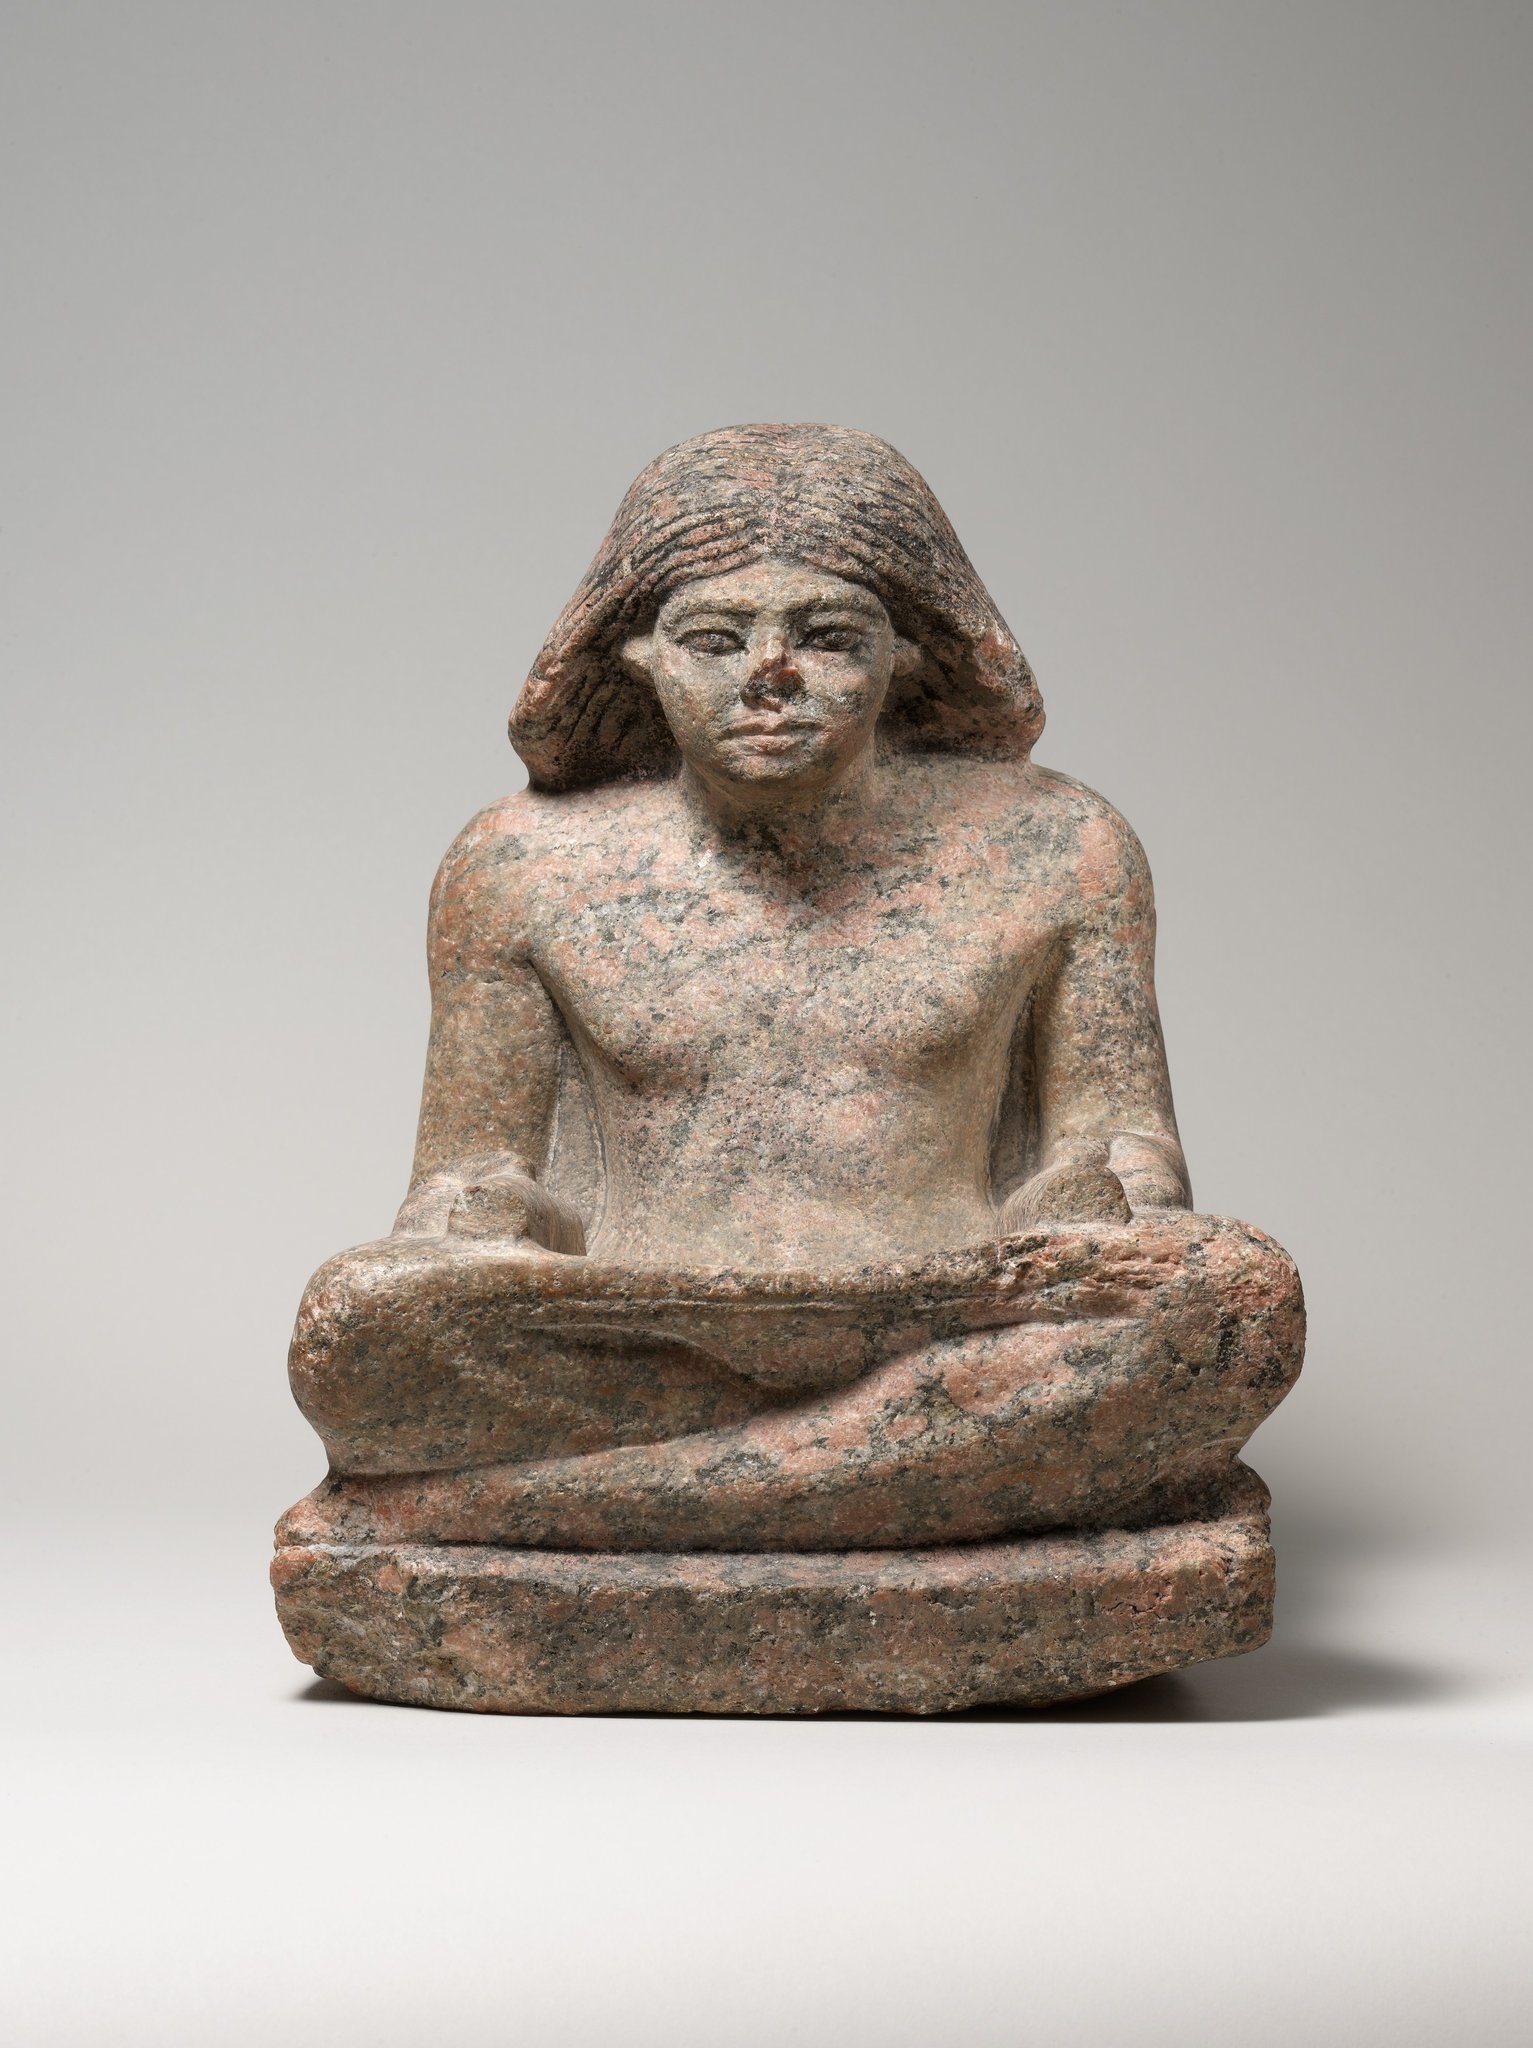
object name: statue, nikare, scribe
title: Nikare as a scribe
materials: granite, paint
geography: egypt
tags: men